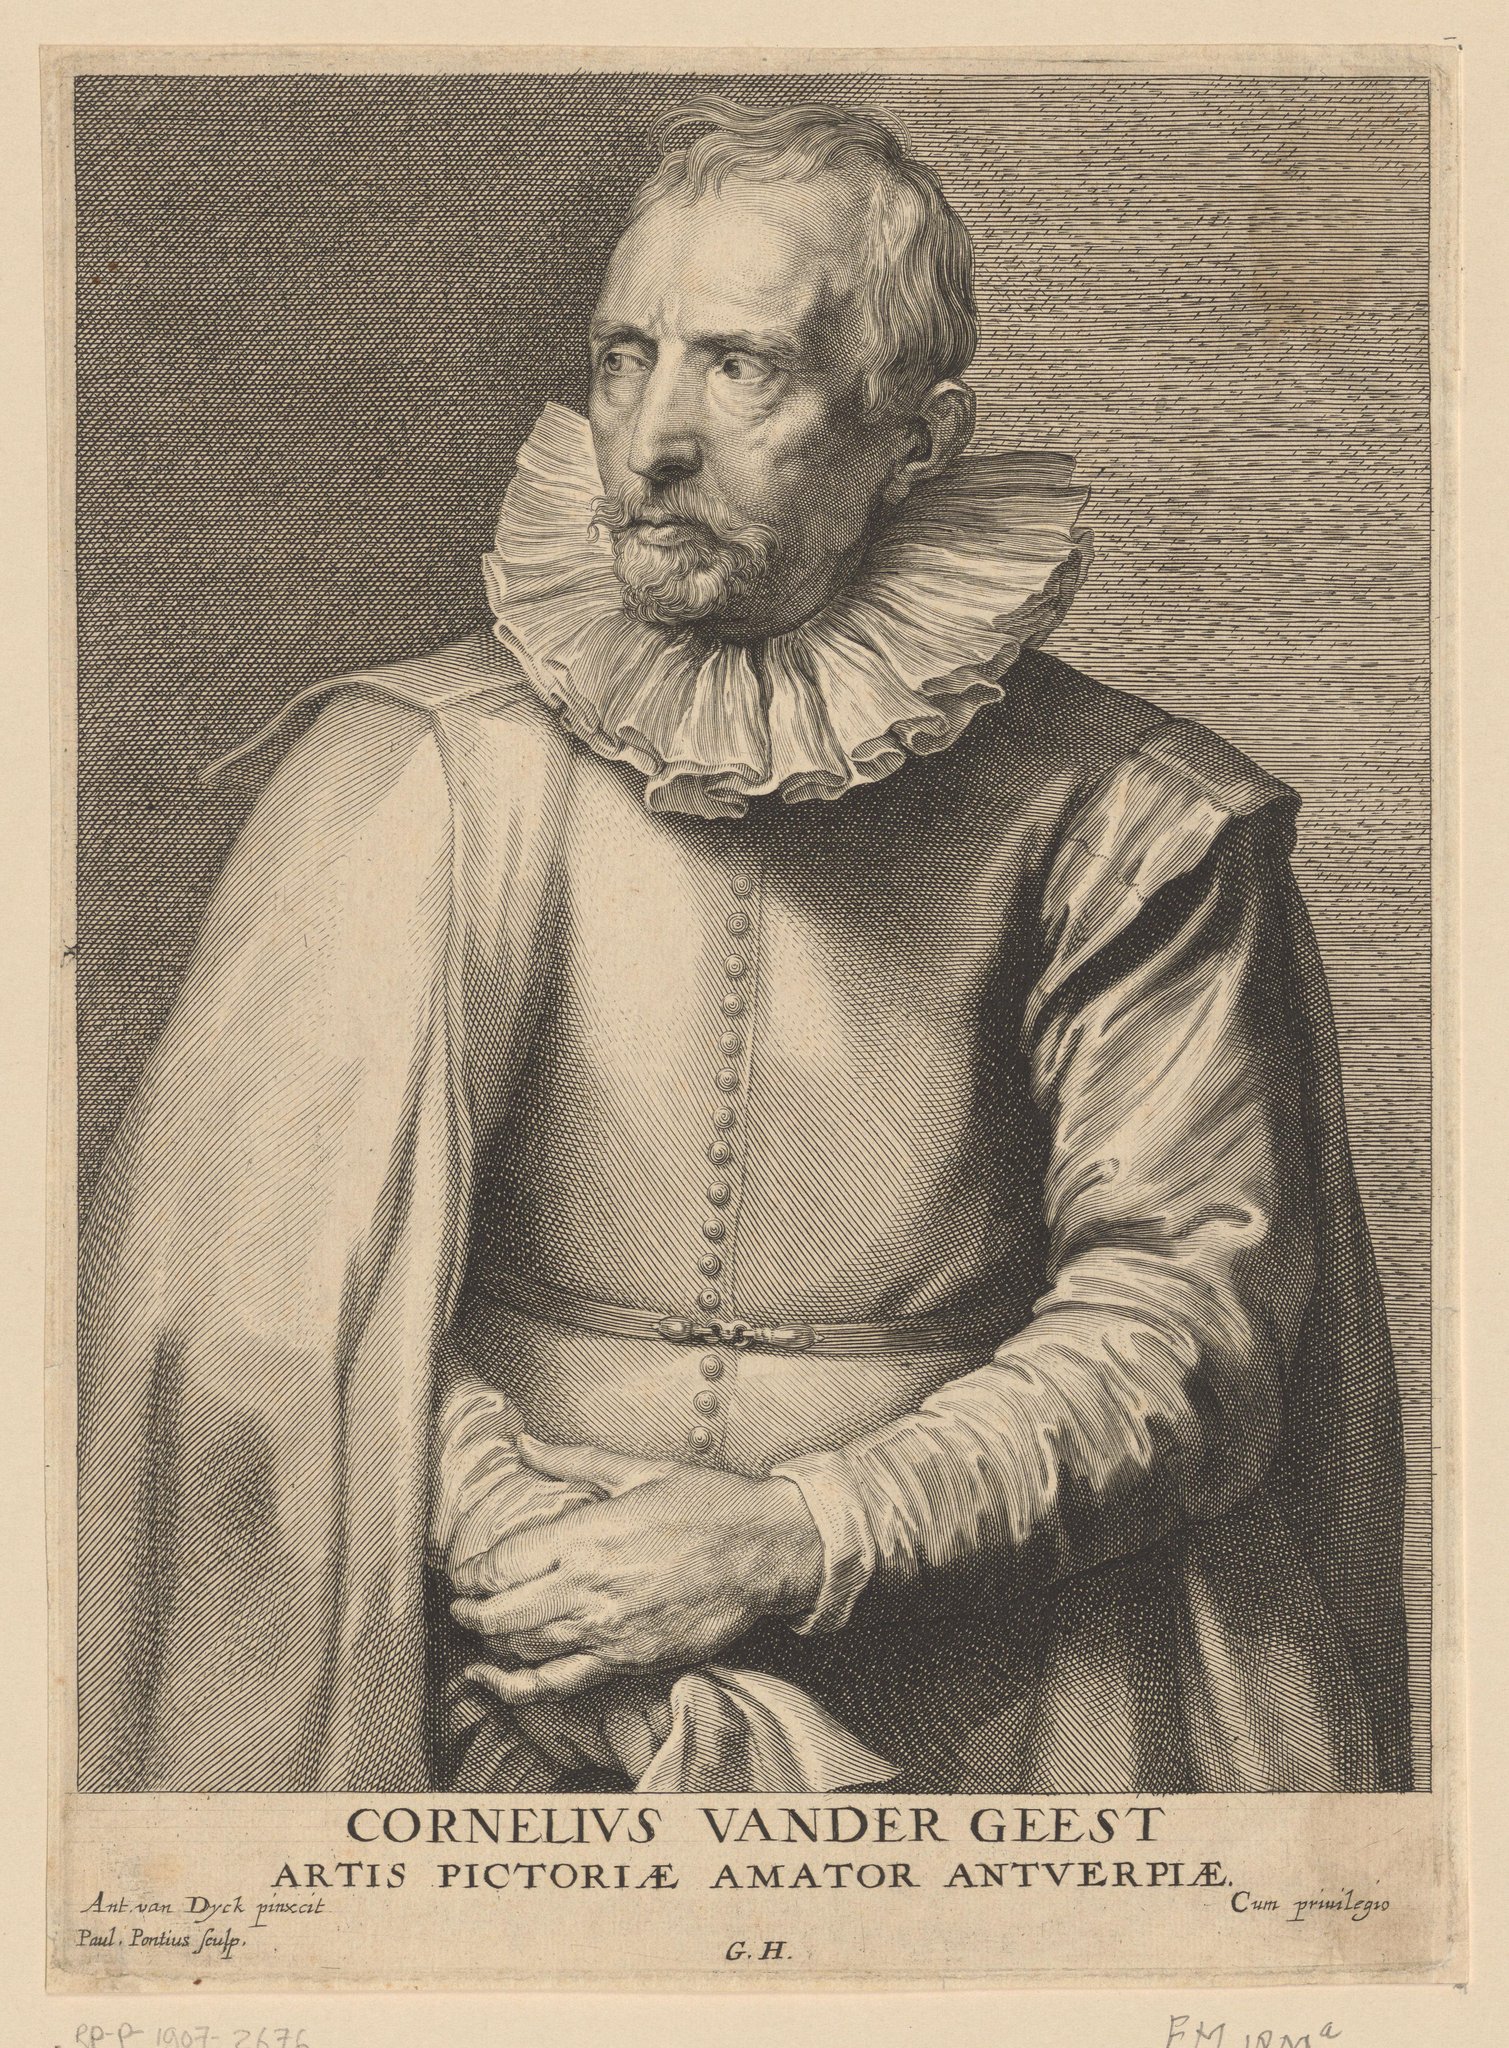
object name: print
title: Portret van Cornelis van der Geest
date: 1630-1641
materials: paper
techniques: engraving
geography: antwerp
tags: cornelis van der geest, historical persons